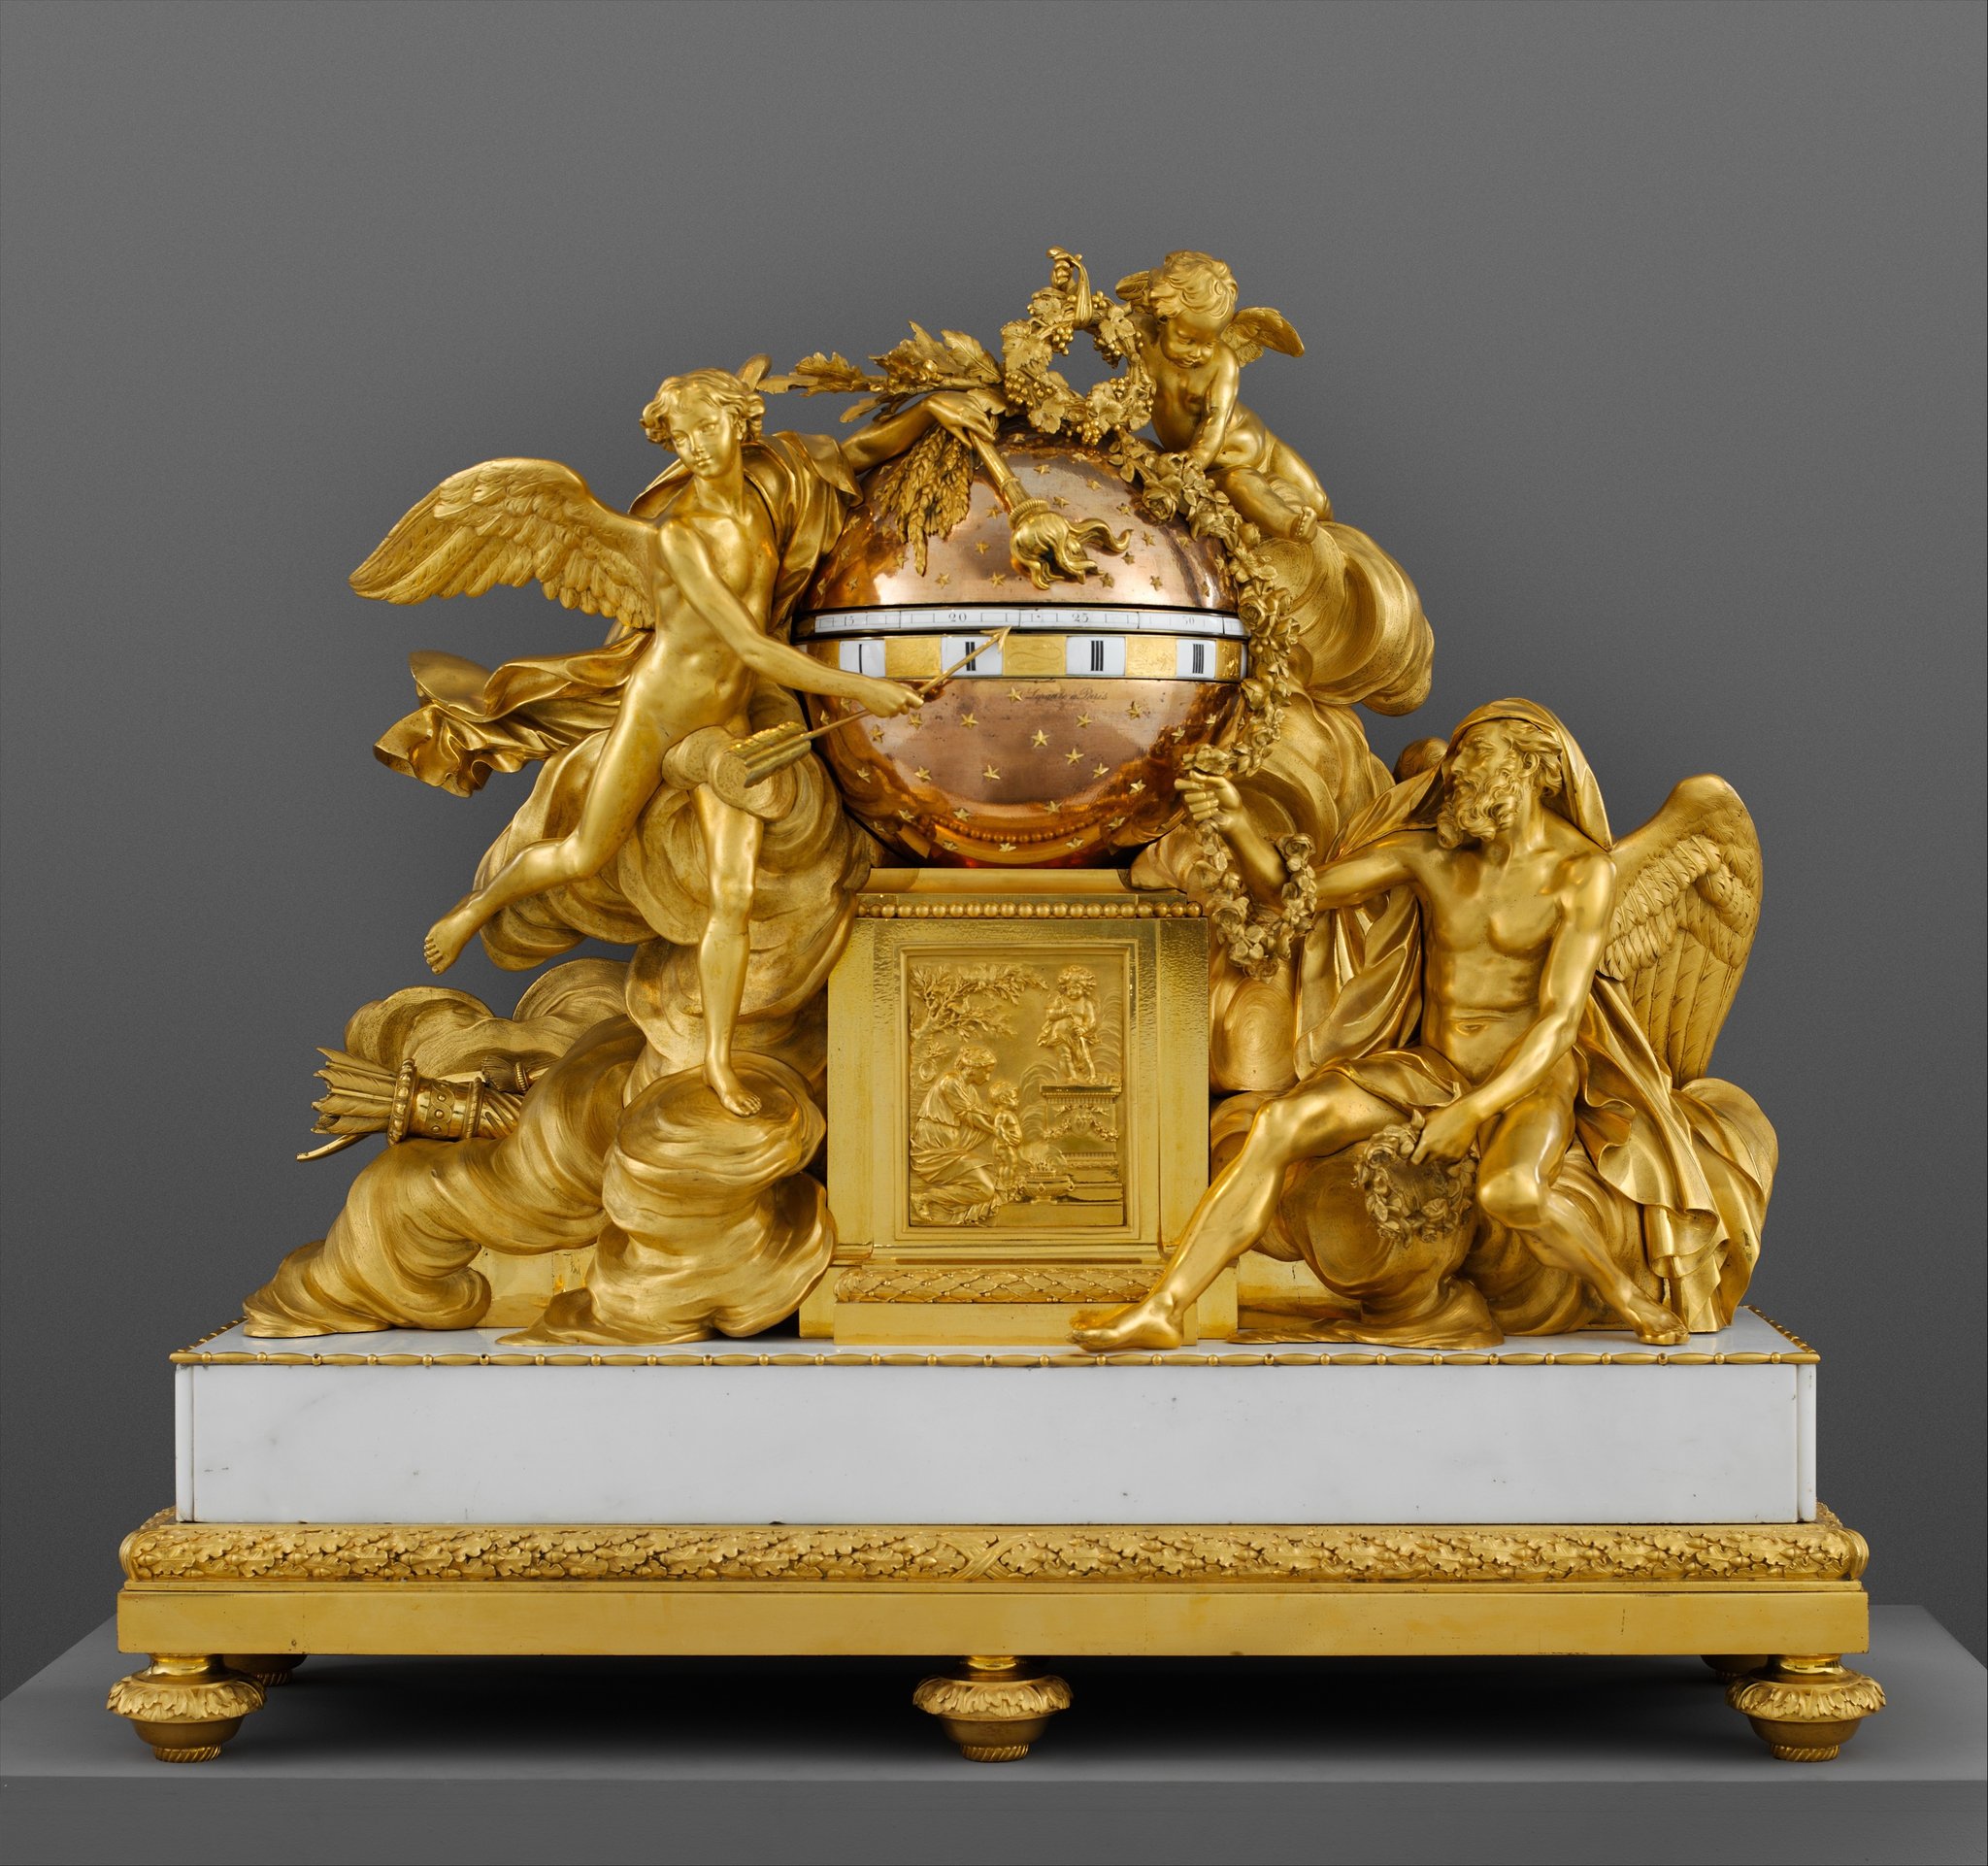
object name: mantel clock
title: The Triumph of Love over Time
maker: jean-baptiste lepaute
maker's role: maker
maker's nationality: french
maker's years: 1727-1802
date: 1780-1790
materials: enamel, gilt bronze, marble